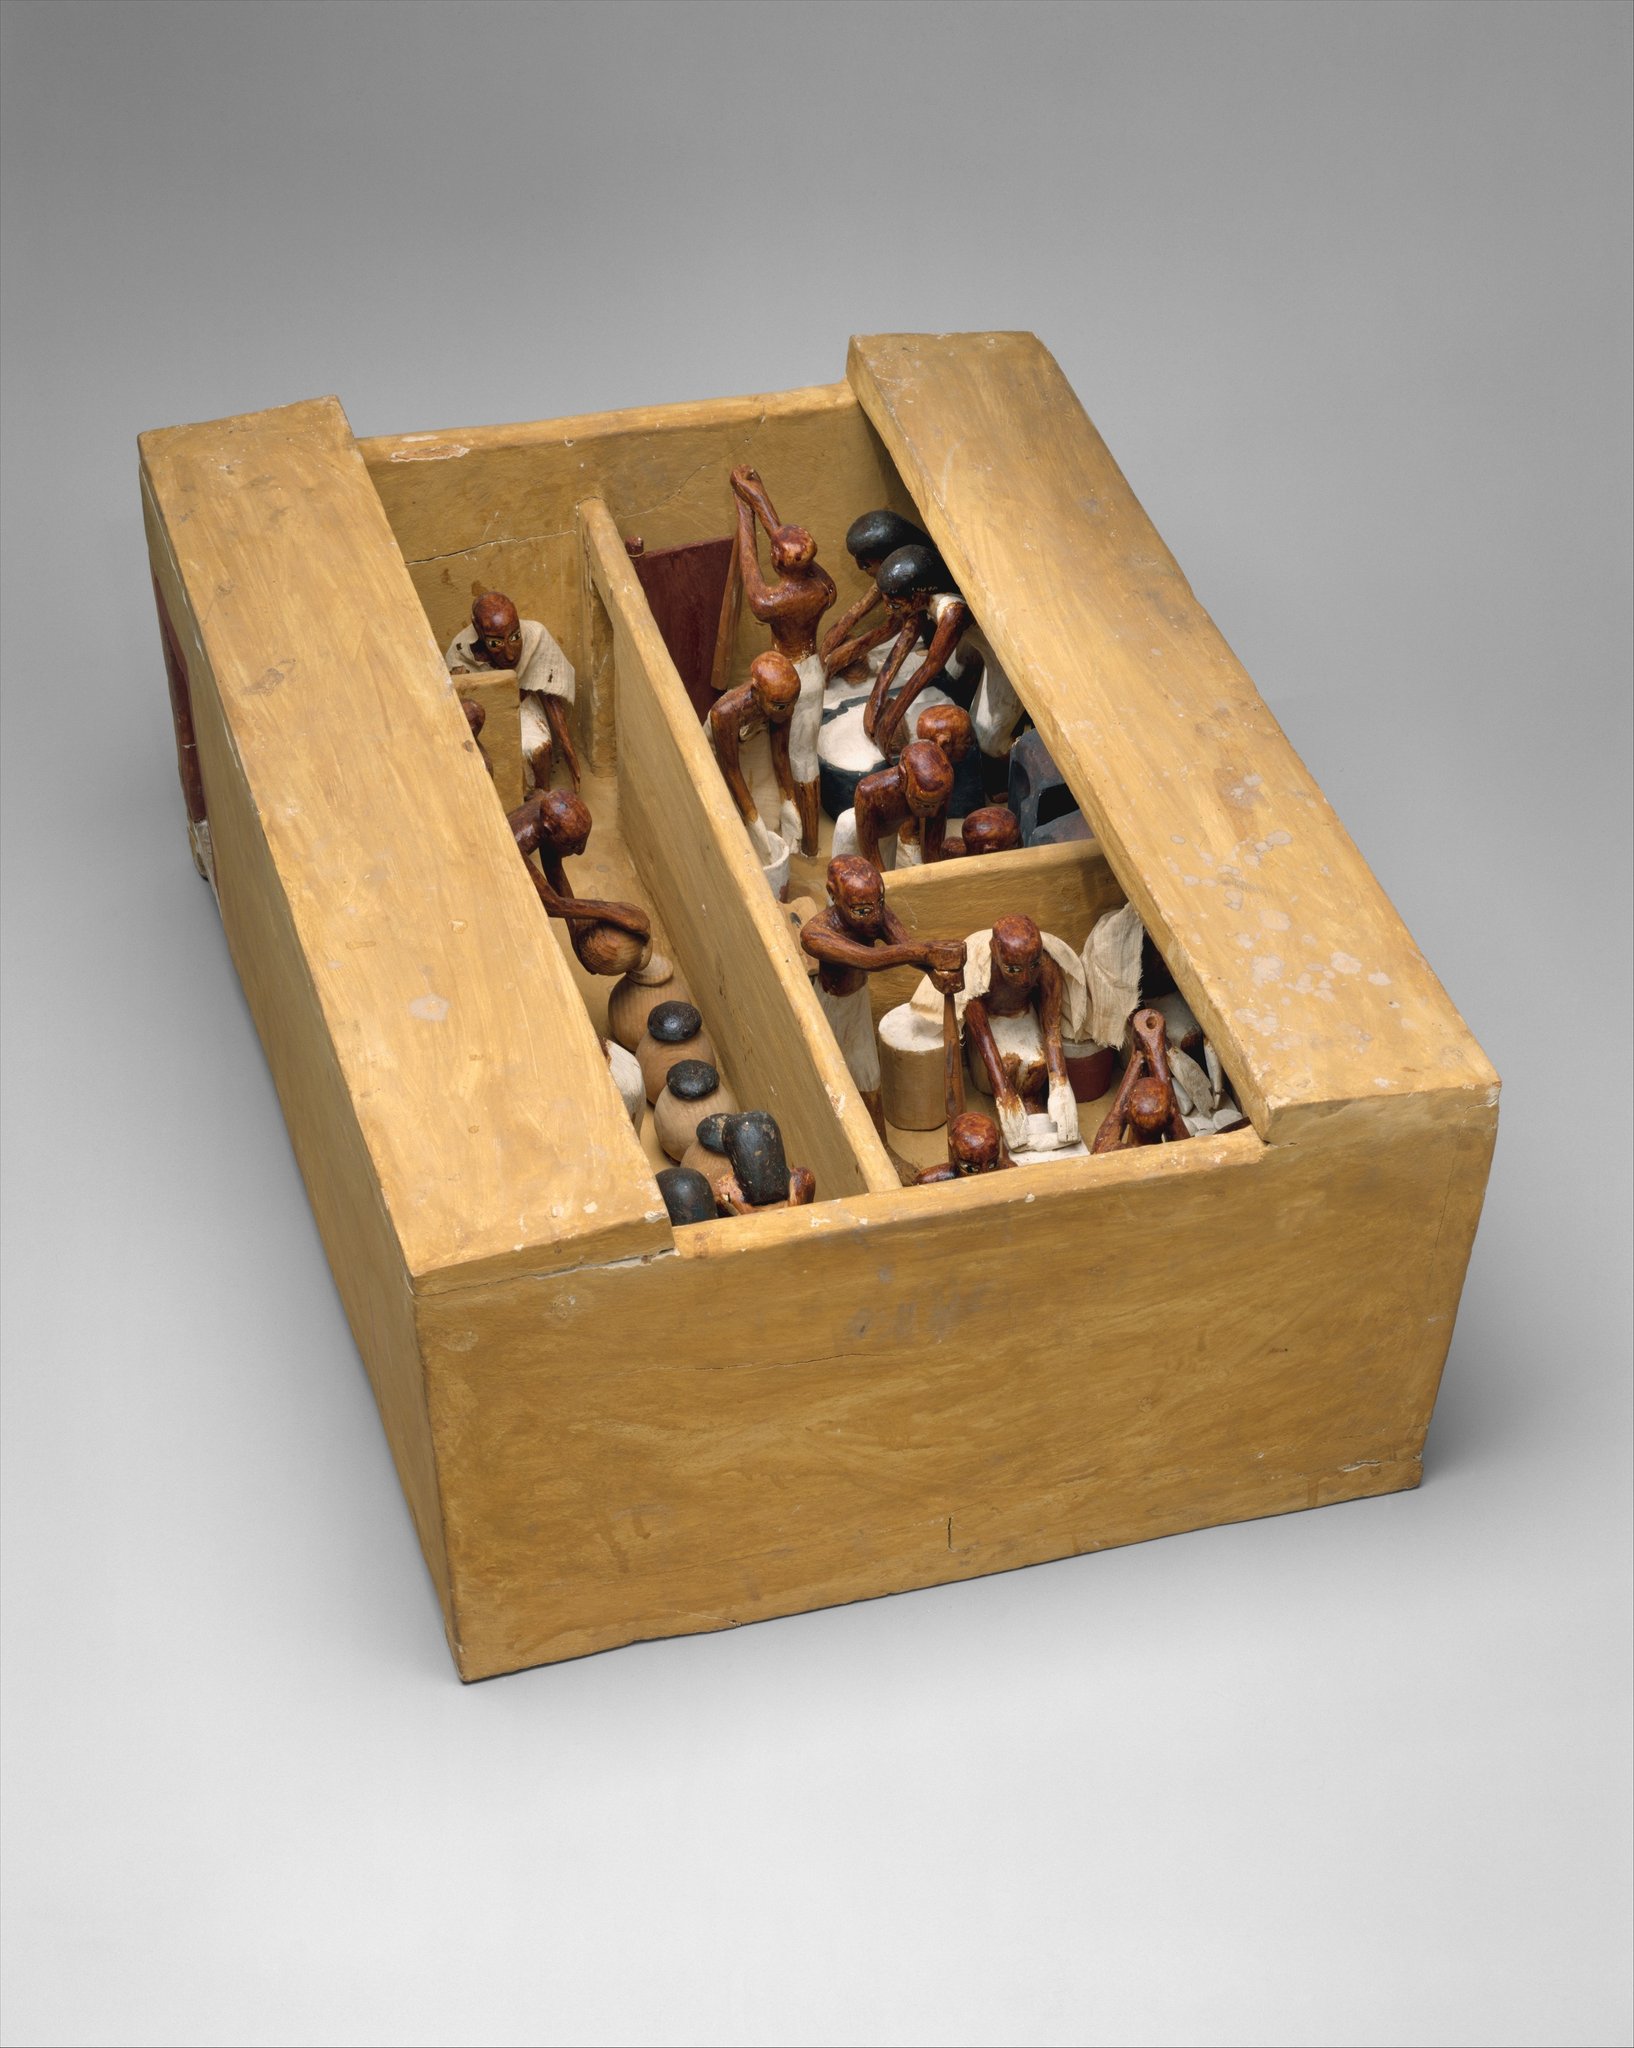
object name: model, bakery, brewery, meketre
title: Model Bakery and Brewery from the Tomb of Meketre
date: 1981-1975 BCE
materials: gesso, linen, paint, wood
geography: egypt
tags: men,working,meketre-models